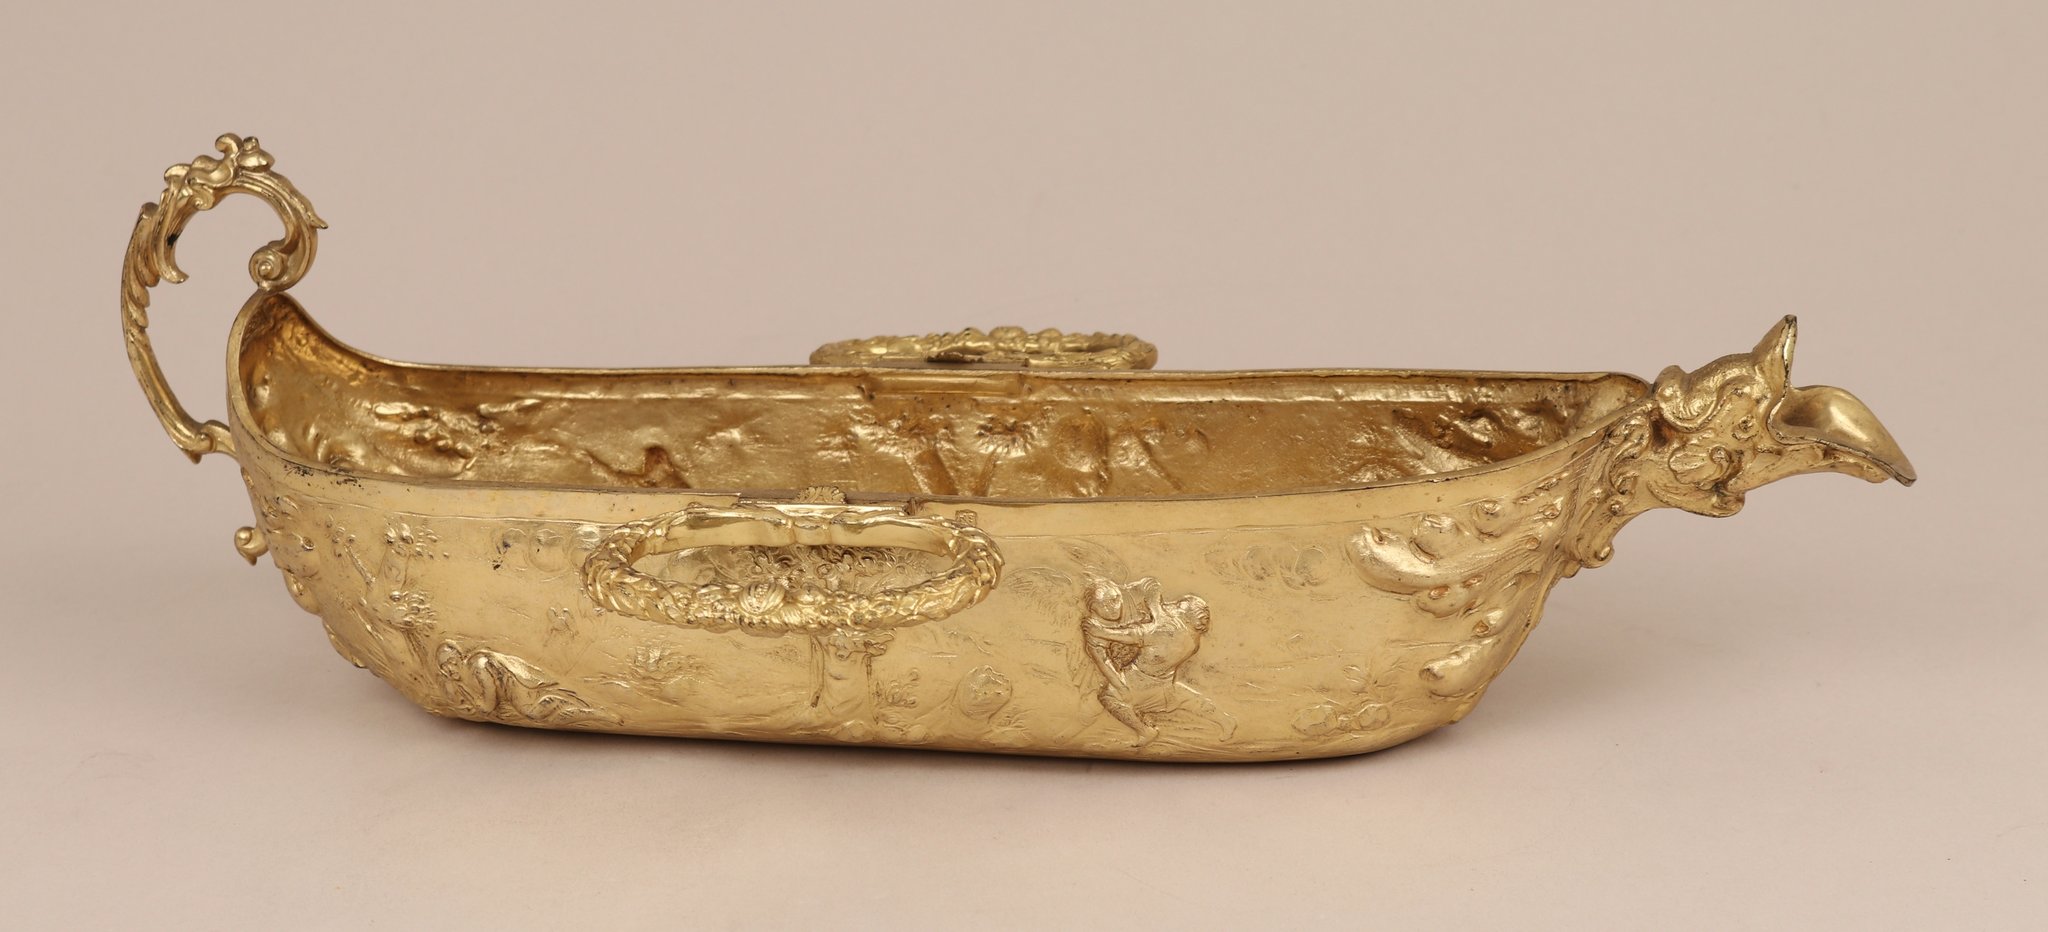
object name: wine cradle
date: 1801-1900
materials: metal, silver